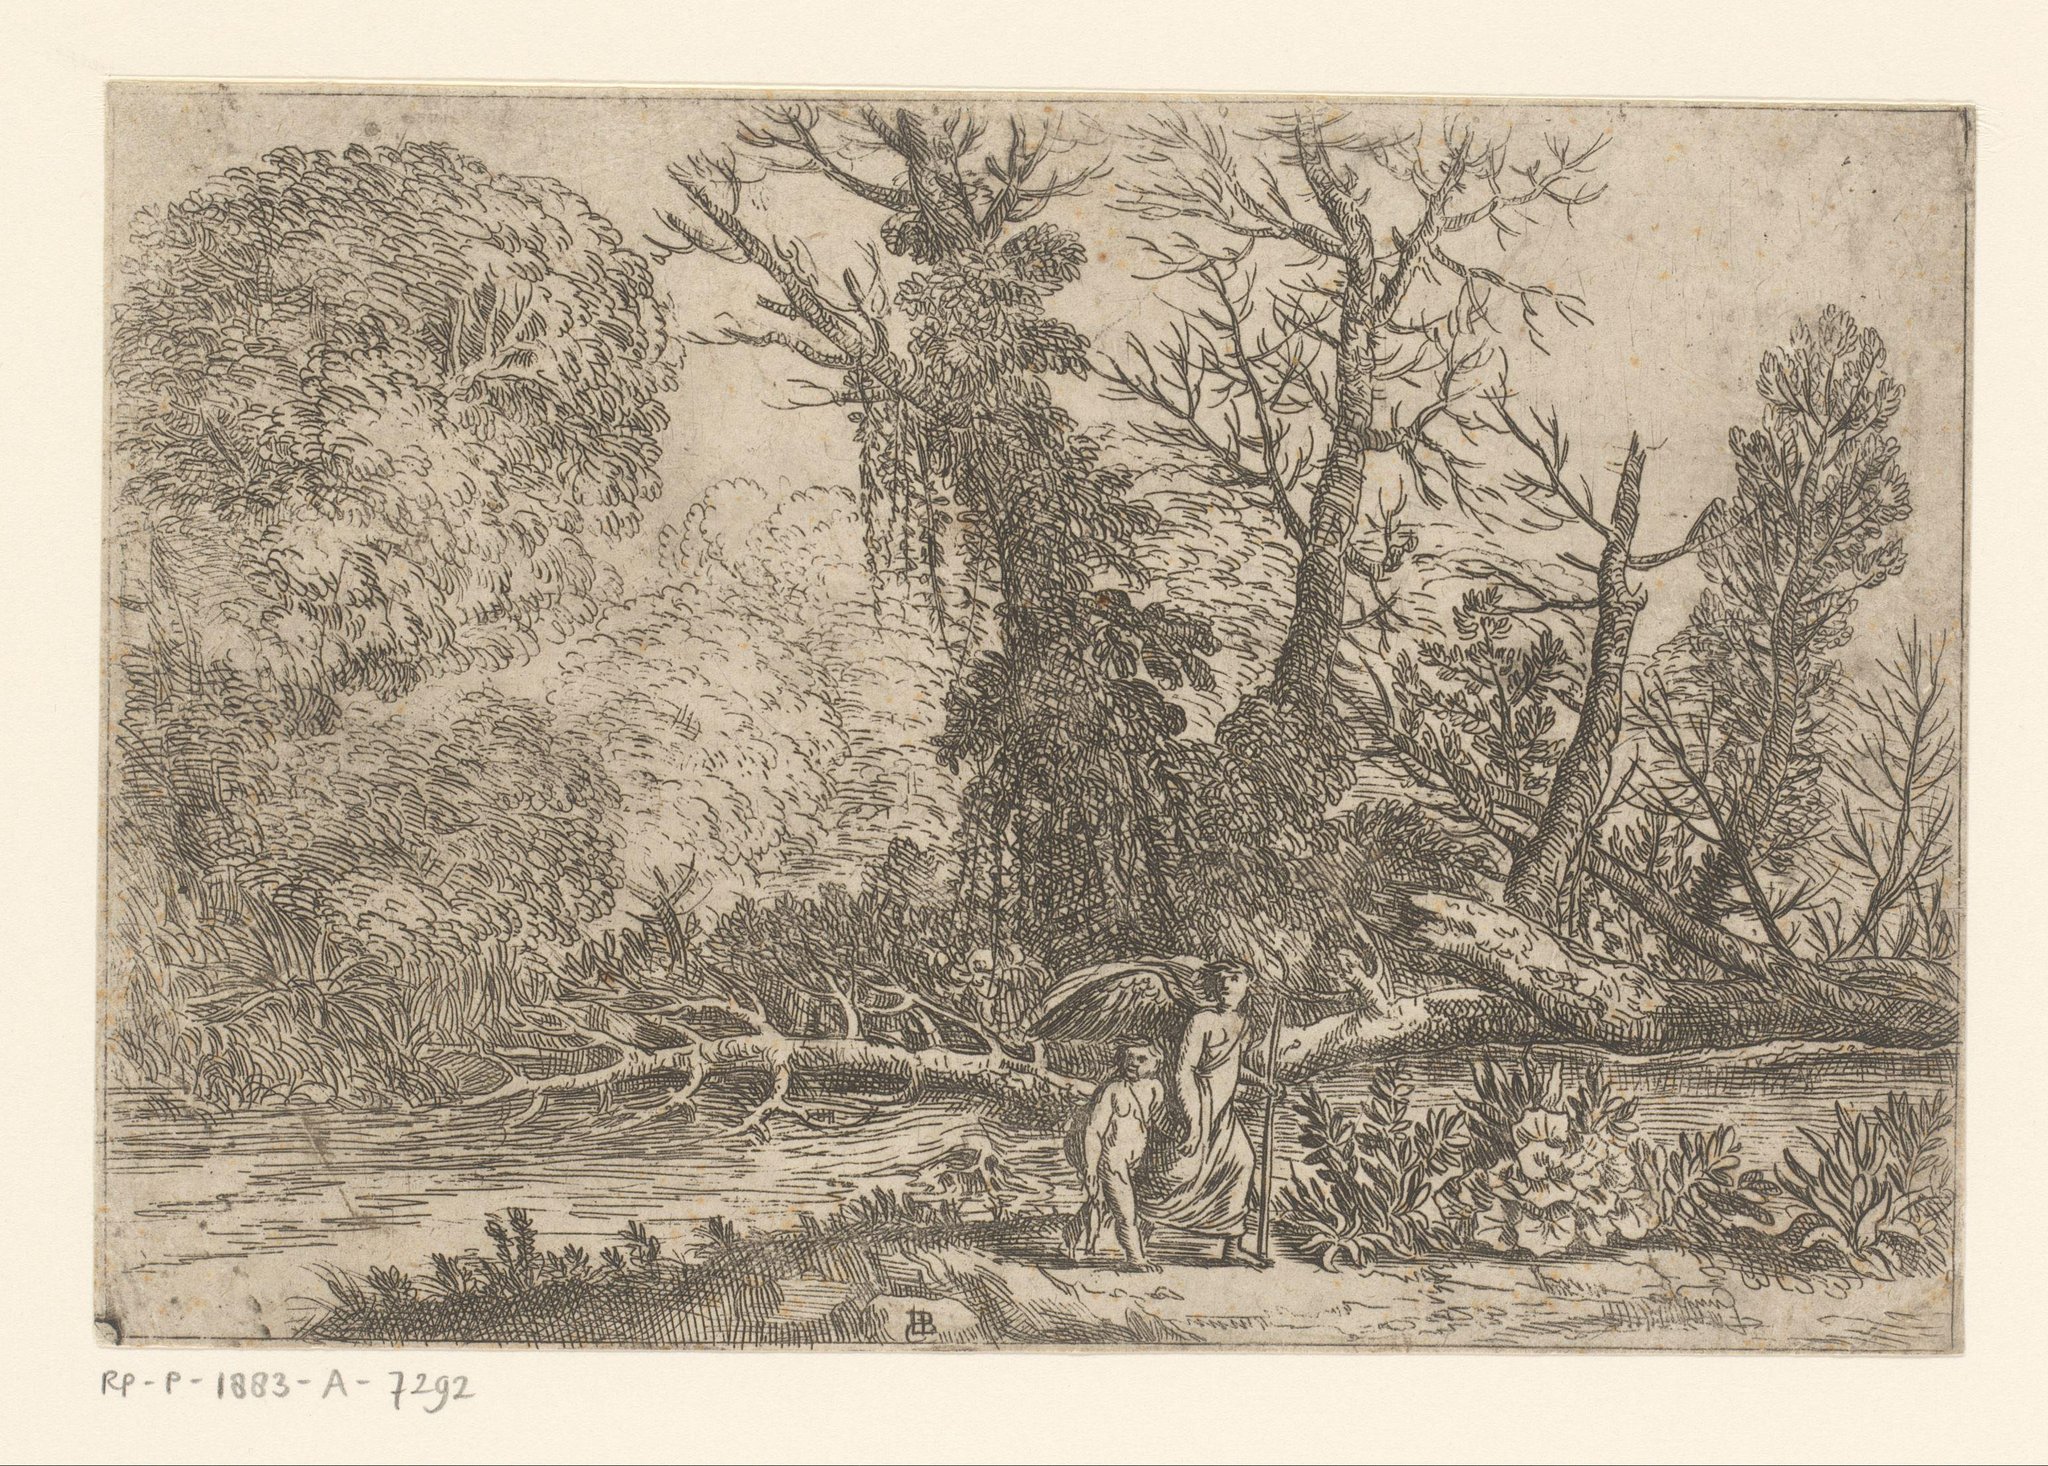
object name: print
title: Tobias en de engel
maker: monogrammist chb of cbb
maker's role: print maker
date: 1600-1699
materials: paper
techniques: etching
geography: low countries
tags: tobias and the angel raphael continue their journey; usually tobias carrying the fish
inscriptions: collector's mark: Lugt 2228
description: Tobias en de aartsengel Rafaël vervolgen hun reis. Tobias draagt de door hem gevangen vis. Achter hen een rivier met een dode boom.